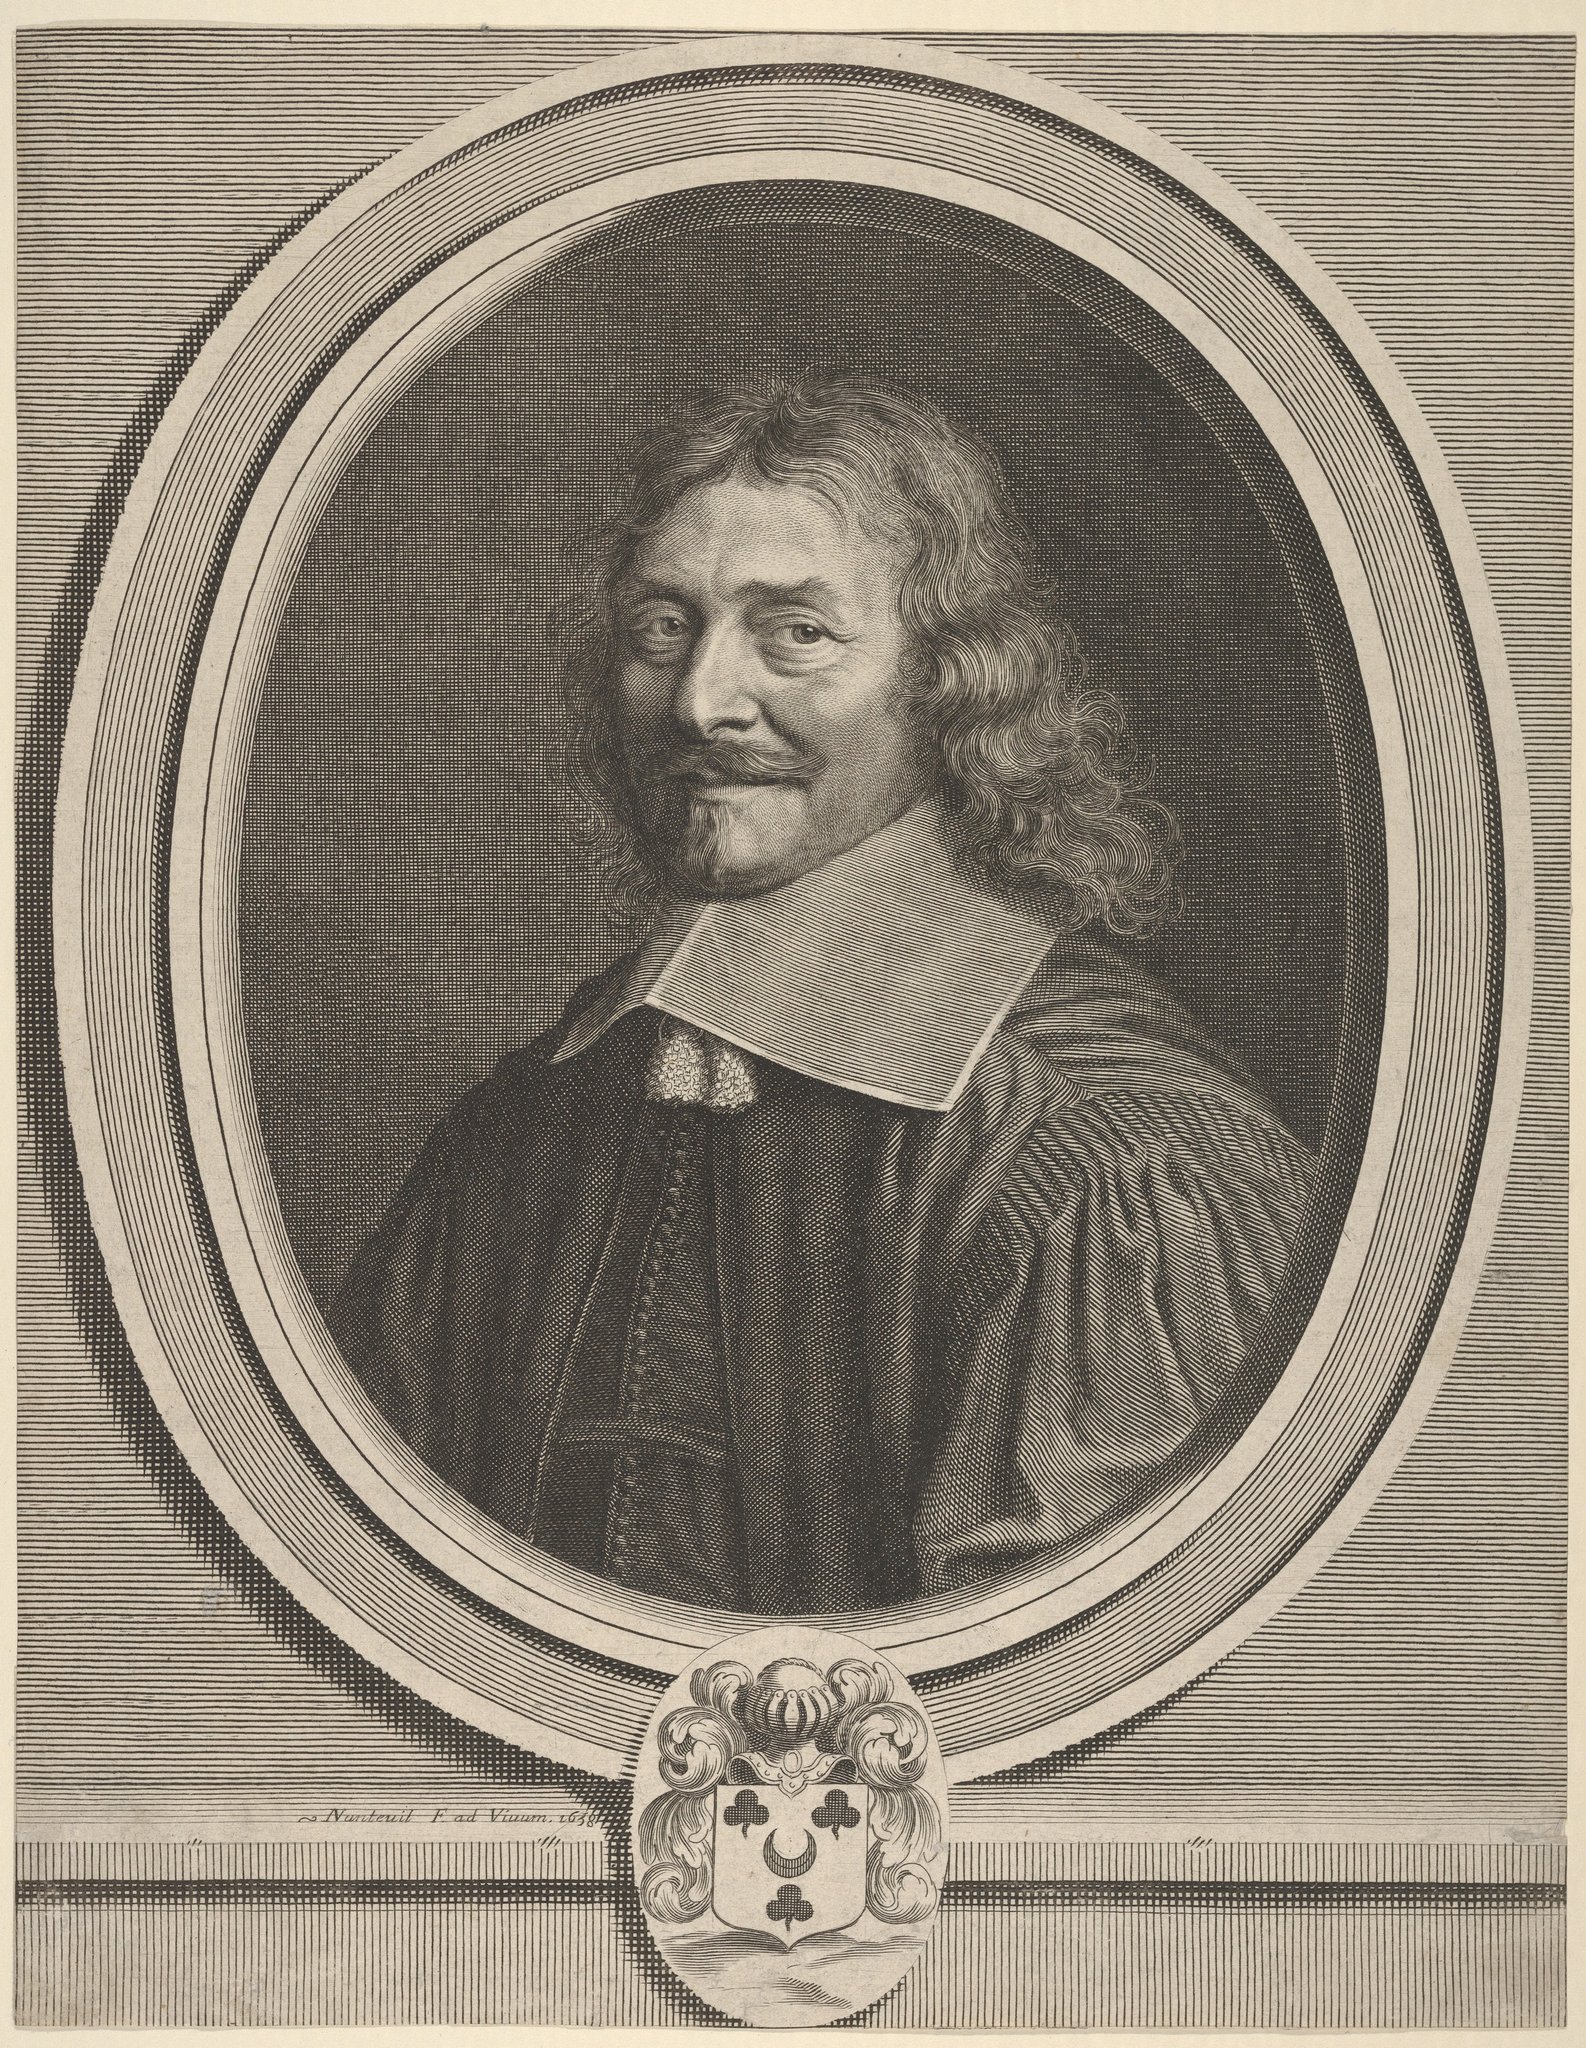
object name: print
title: Simon Dreux d'Aubray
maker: robert nanteuil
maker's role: artist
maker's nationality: french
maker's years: 1623-1678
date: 1658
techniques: engraving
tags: men,portraits,coat of arms